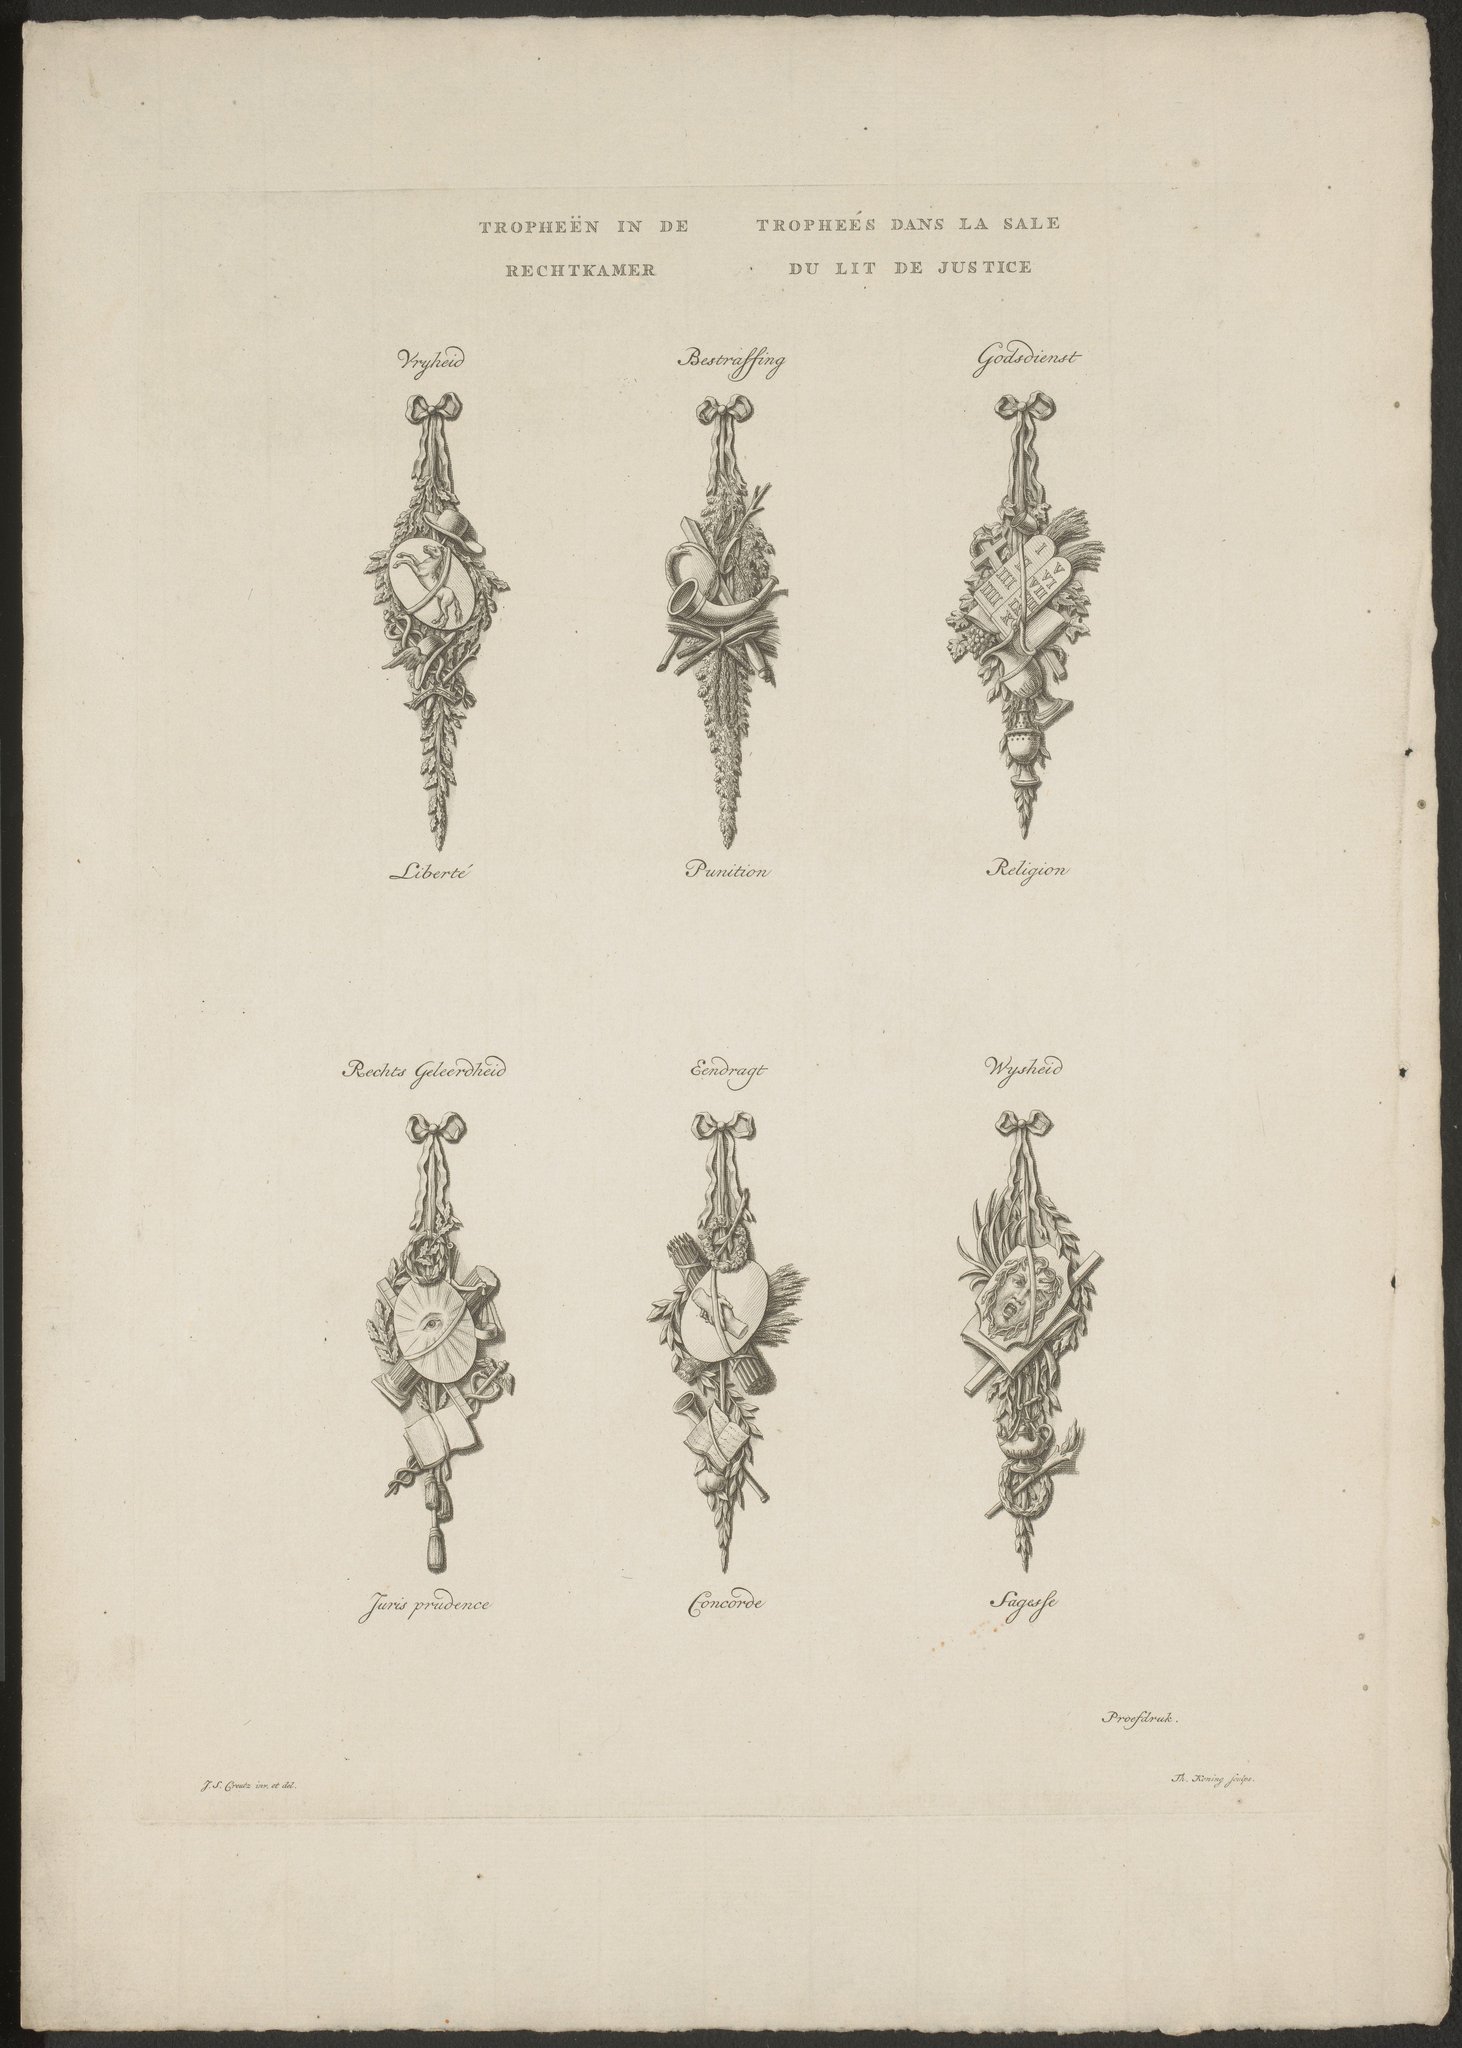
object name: print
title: Afbeeldingen van de rechtbank te Westzaan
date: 1782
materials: paper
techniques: etching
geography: amsterdam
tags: concord, 'concordia' ~ one of the seven gifts of the soul, instruments of torture, execution or punishment (with name), faith, 'fides'; 'fede', 'fede catholica', 'fede christiana', 'fede christiana catholica' (ripa) ~ one of the three theological virtues, wisdom; 'sapienza', 'sapienza humana', 'sapienza vera' (ripa), freedom, liberty; 'libertà' (ripa), symbols and allegories of jurisprudence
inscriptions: collector's mark: Lugt 2228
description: Blad met zes trofeeën met allegorische objecten, hangende in de rechtkamer van de nieuwe rechtbank te Westzaan. Boven Vrijheid, Bestraffing en Godsdienst en onder Rechtsgeleerdheid, Eendracht en Wijsheid. De prent maakt deel uit van een serie met tien afbeeldingen van de rechtbank te Westzaan.